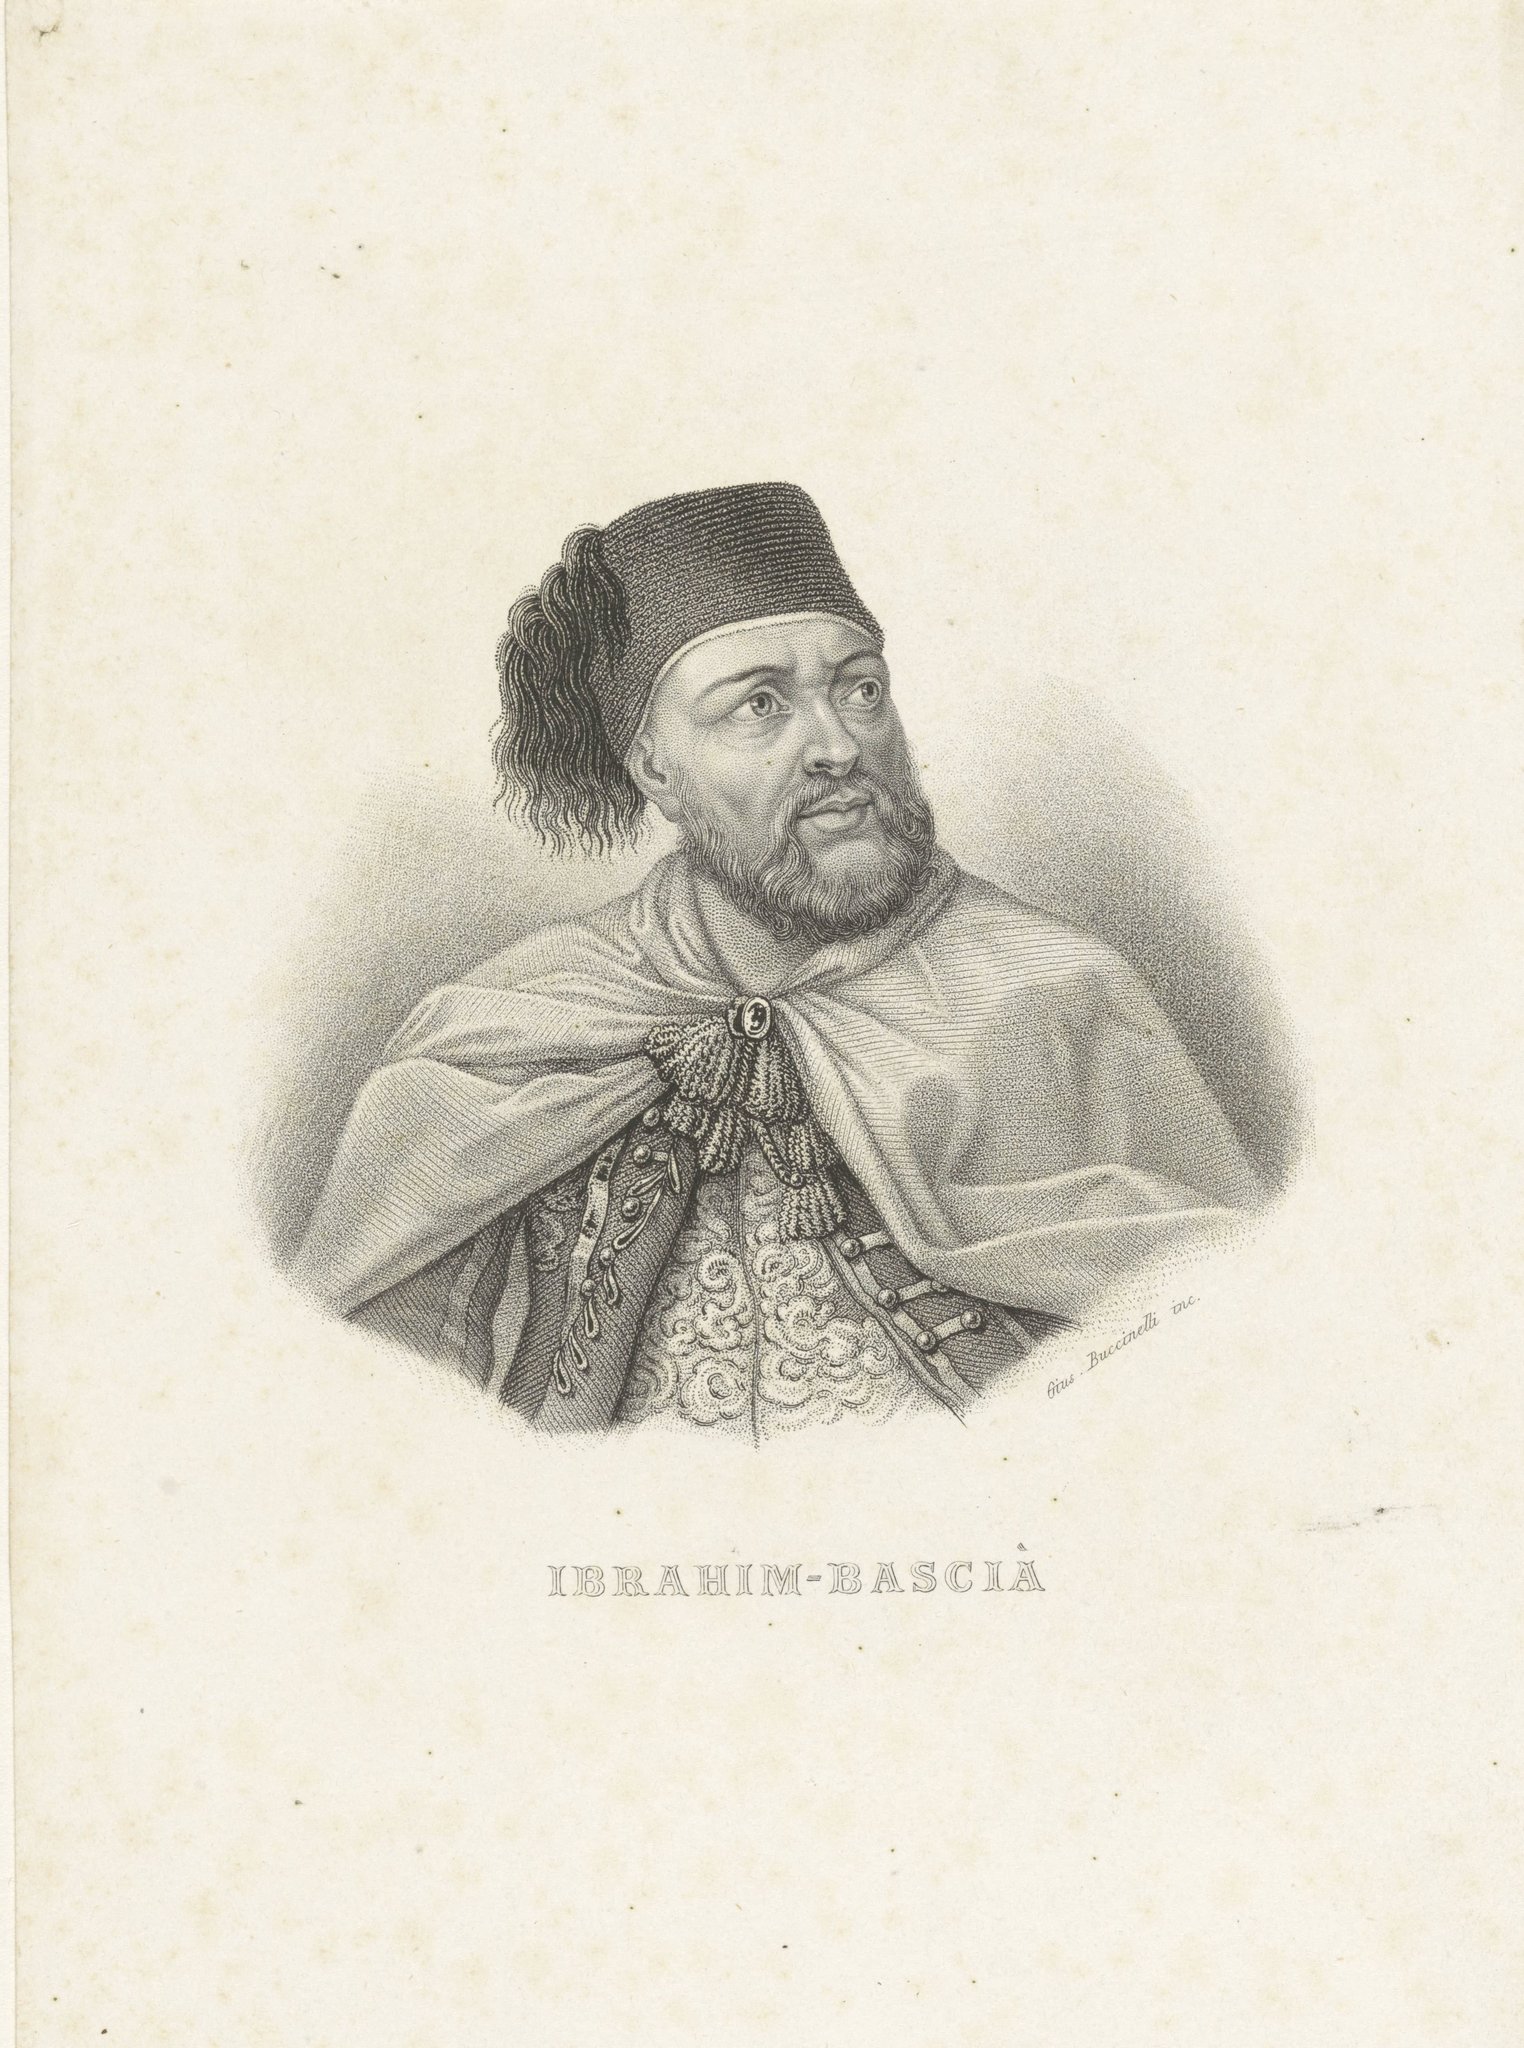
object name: print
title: Portret van Ibrahim Bascia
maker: giuseppe buccinelli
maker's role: print maker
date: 1800-1899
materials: paper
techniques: etching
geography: italy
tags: historical persons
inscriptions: collector's mark: Lugt 2228